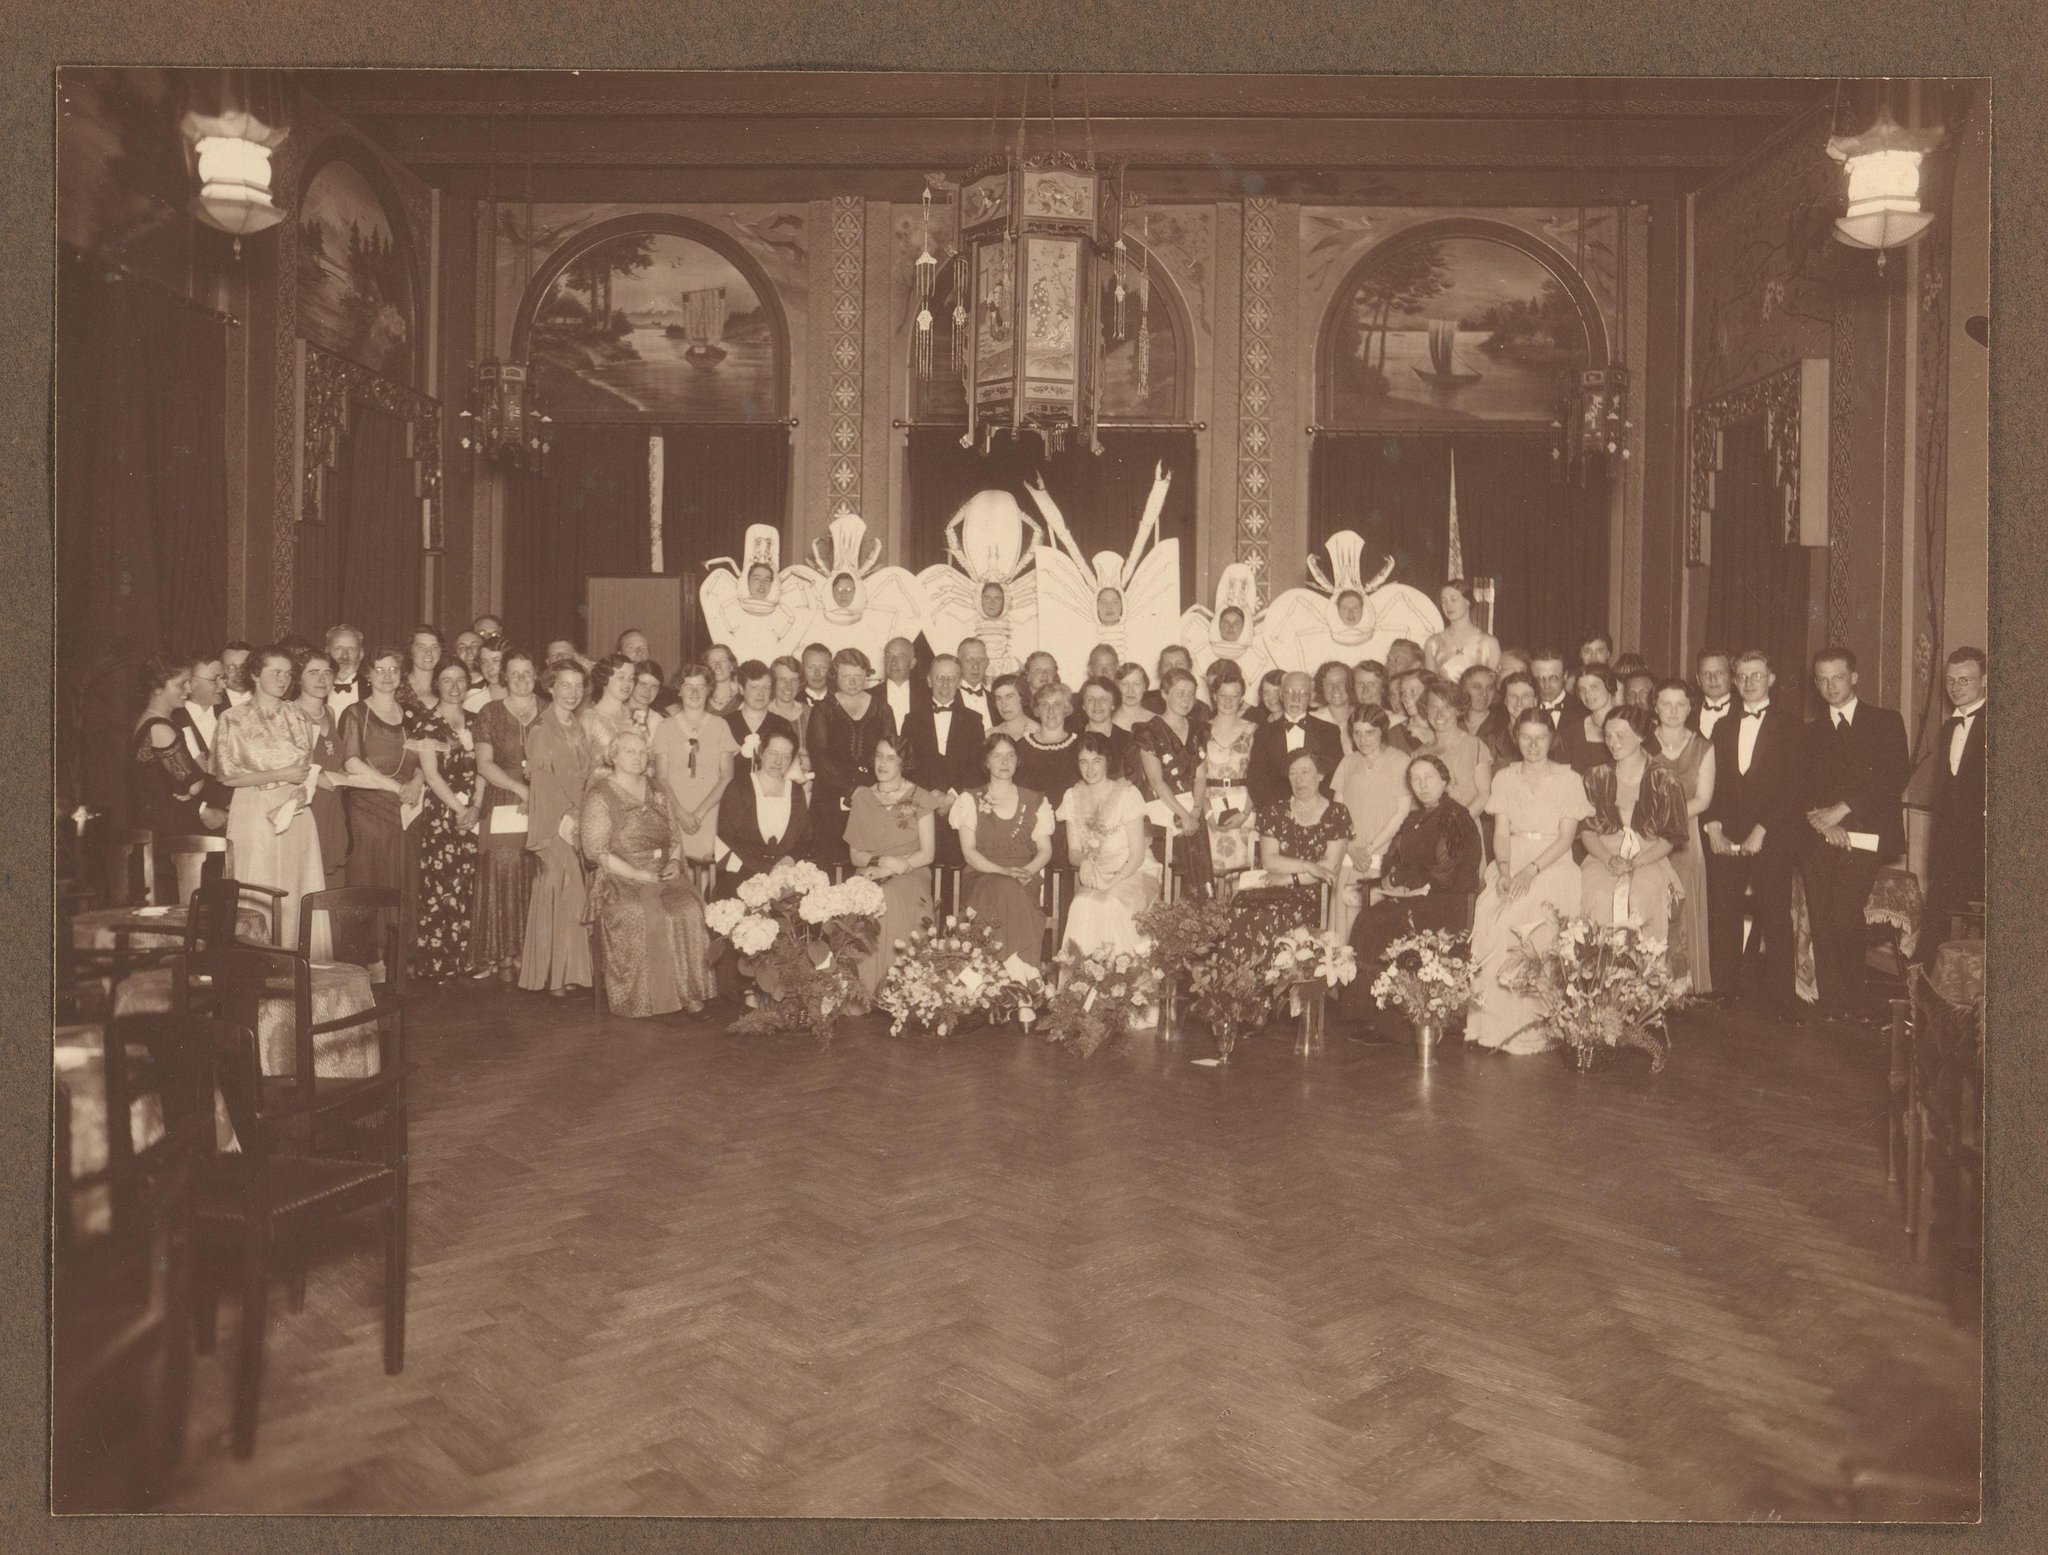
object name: photograph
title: Groepsportret in zaal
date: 1900-1915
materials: photographic support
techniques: photography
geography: netherlands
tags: netherlands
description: Foto op bruin albumblad 51 van familiealbum van Alphons Diepenbrock.